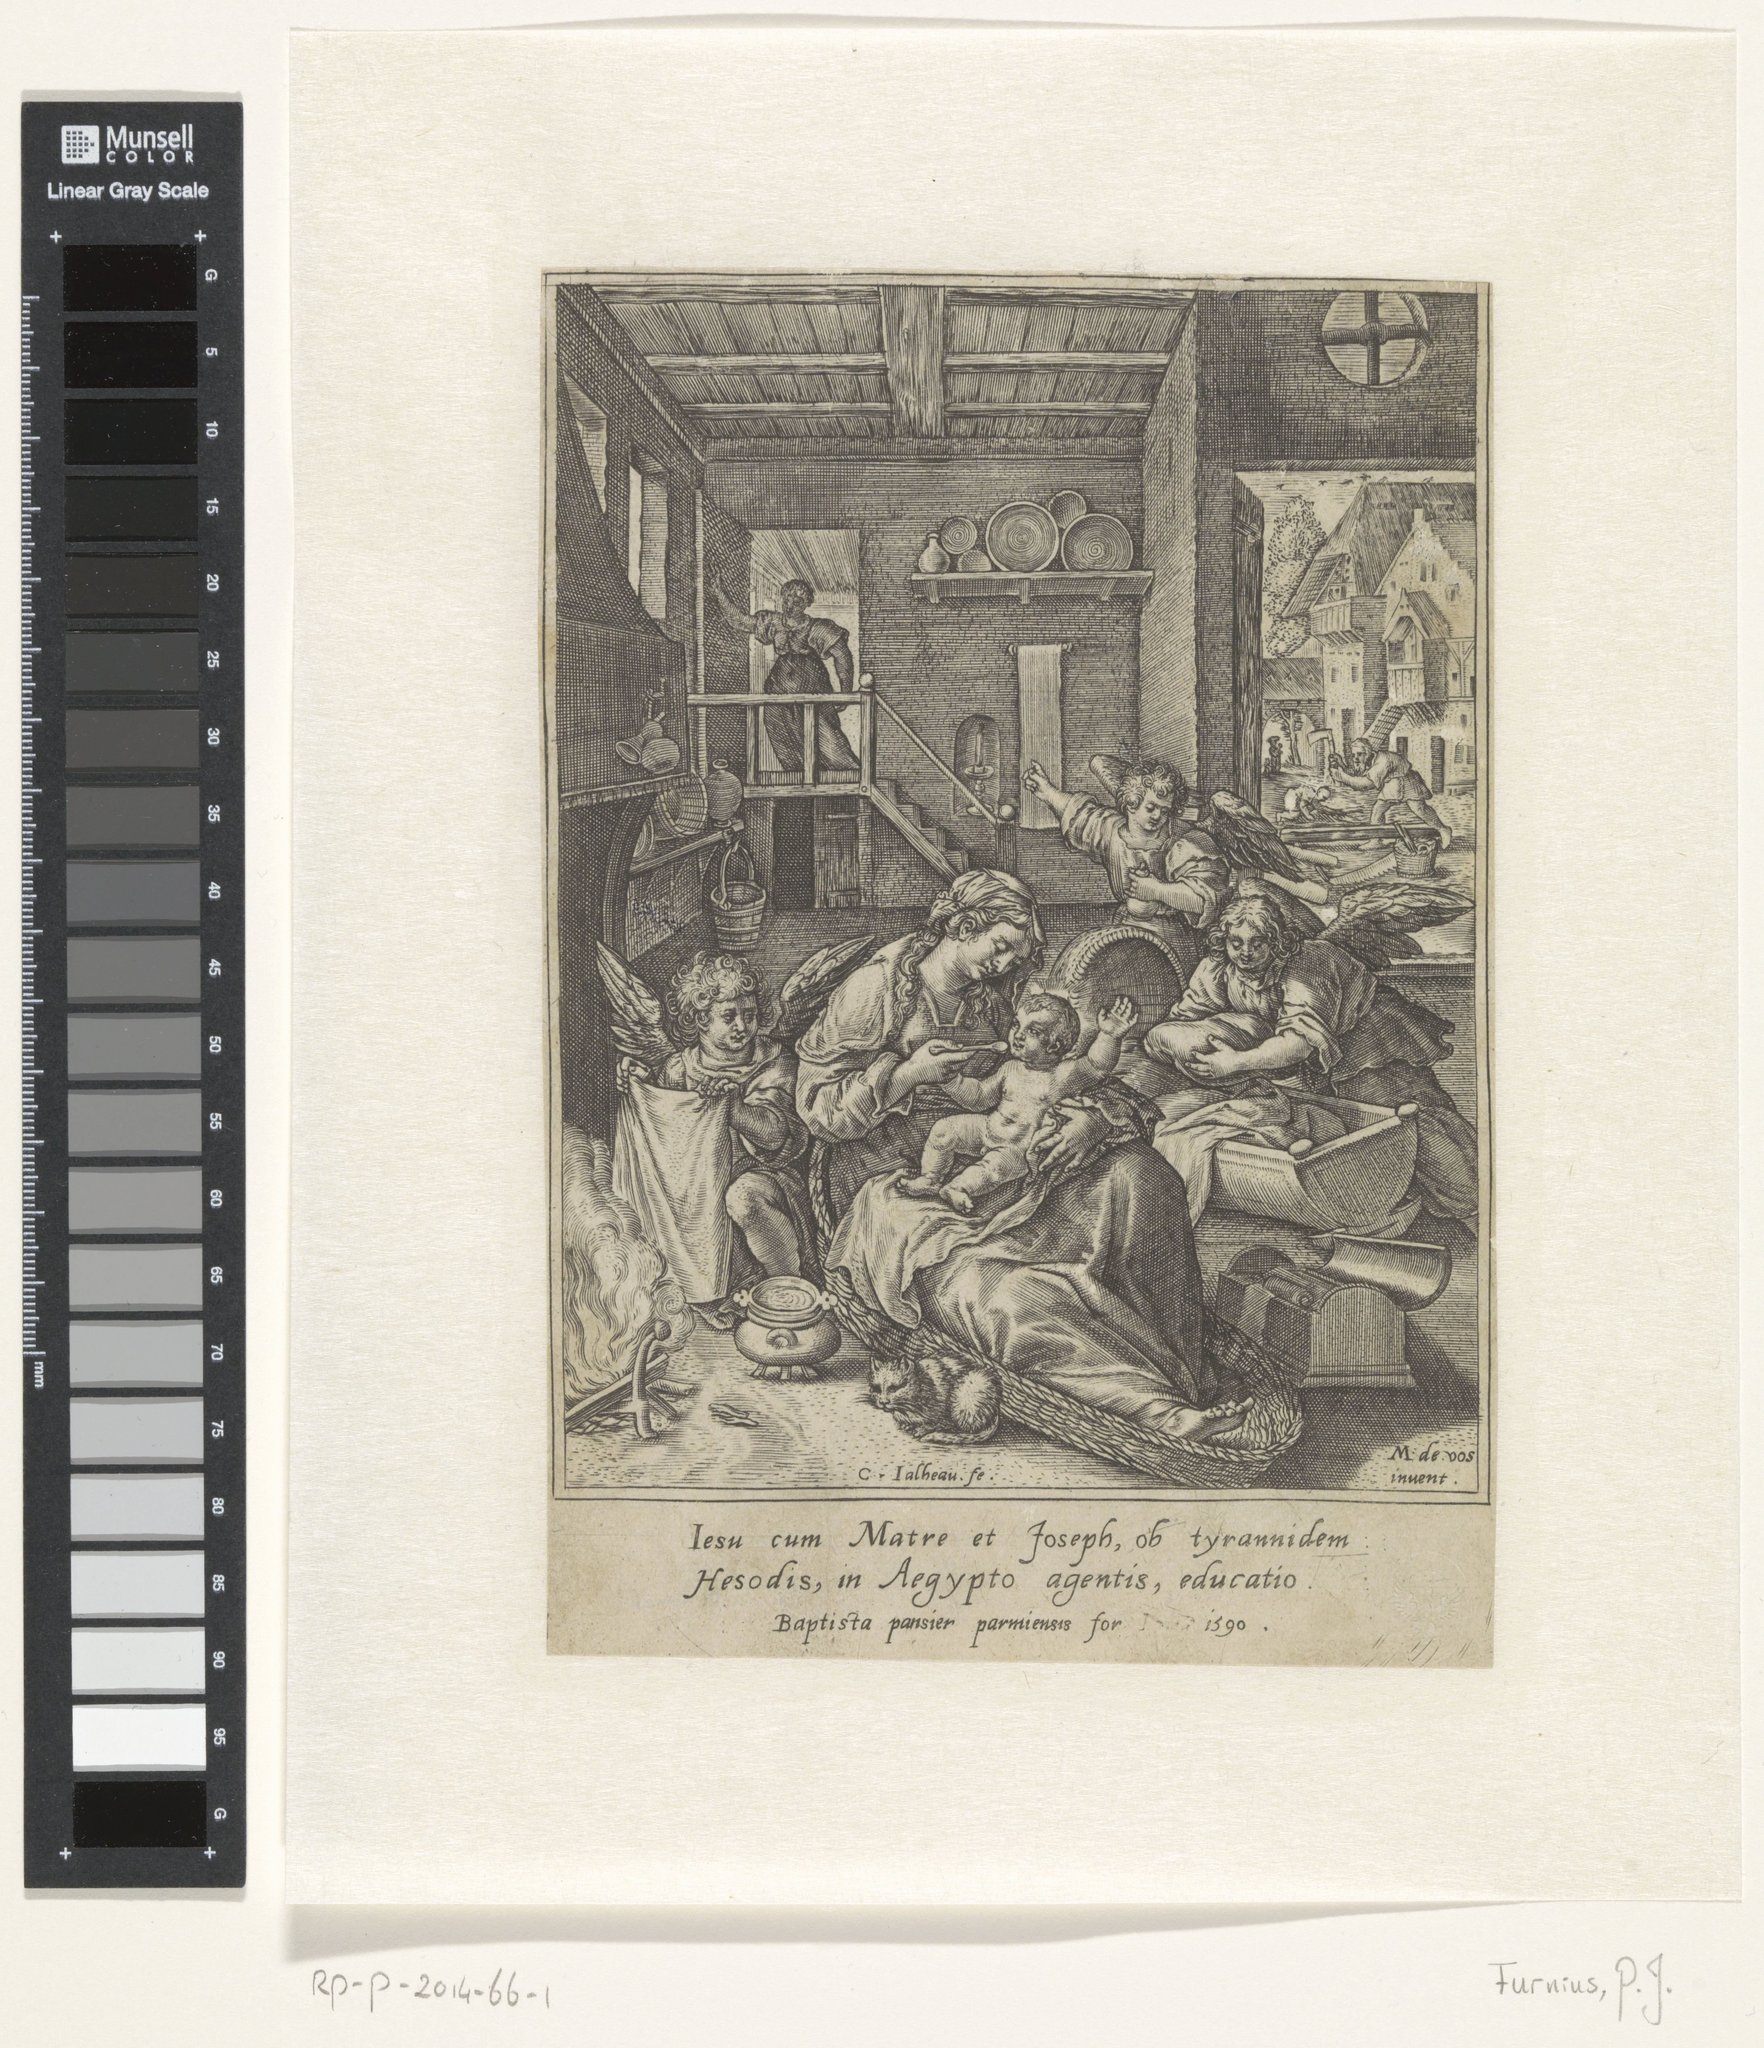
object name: print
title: Heilige Familie in Egypte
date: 1581-1590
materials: paper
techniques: engraving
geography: southern netherlands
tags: stay of the holy family in egypt (+ angel(s)), holy family, and derived representations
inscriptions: collector's mark: Lugt 2810, collector's mark: Lugt 2228, collector's mark: Lugt 2760, collector's mark: Lugt 5k, collector's mark: 3974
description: Interieur met de Heilige Familie in Egypte. Maria voert het Christuskind pap terwijl engelen helpen in het huishouden. Op de achtergrond timmert Josef.